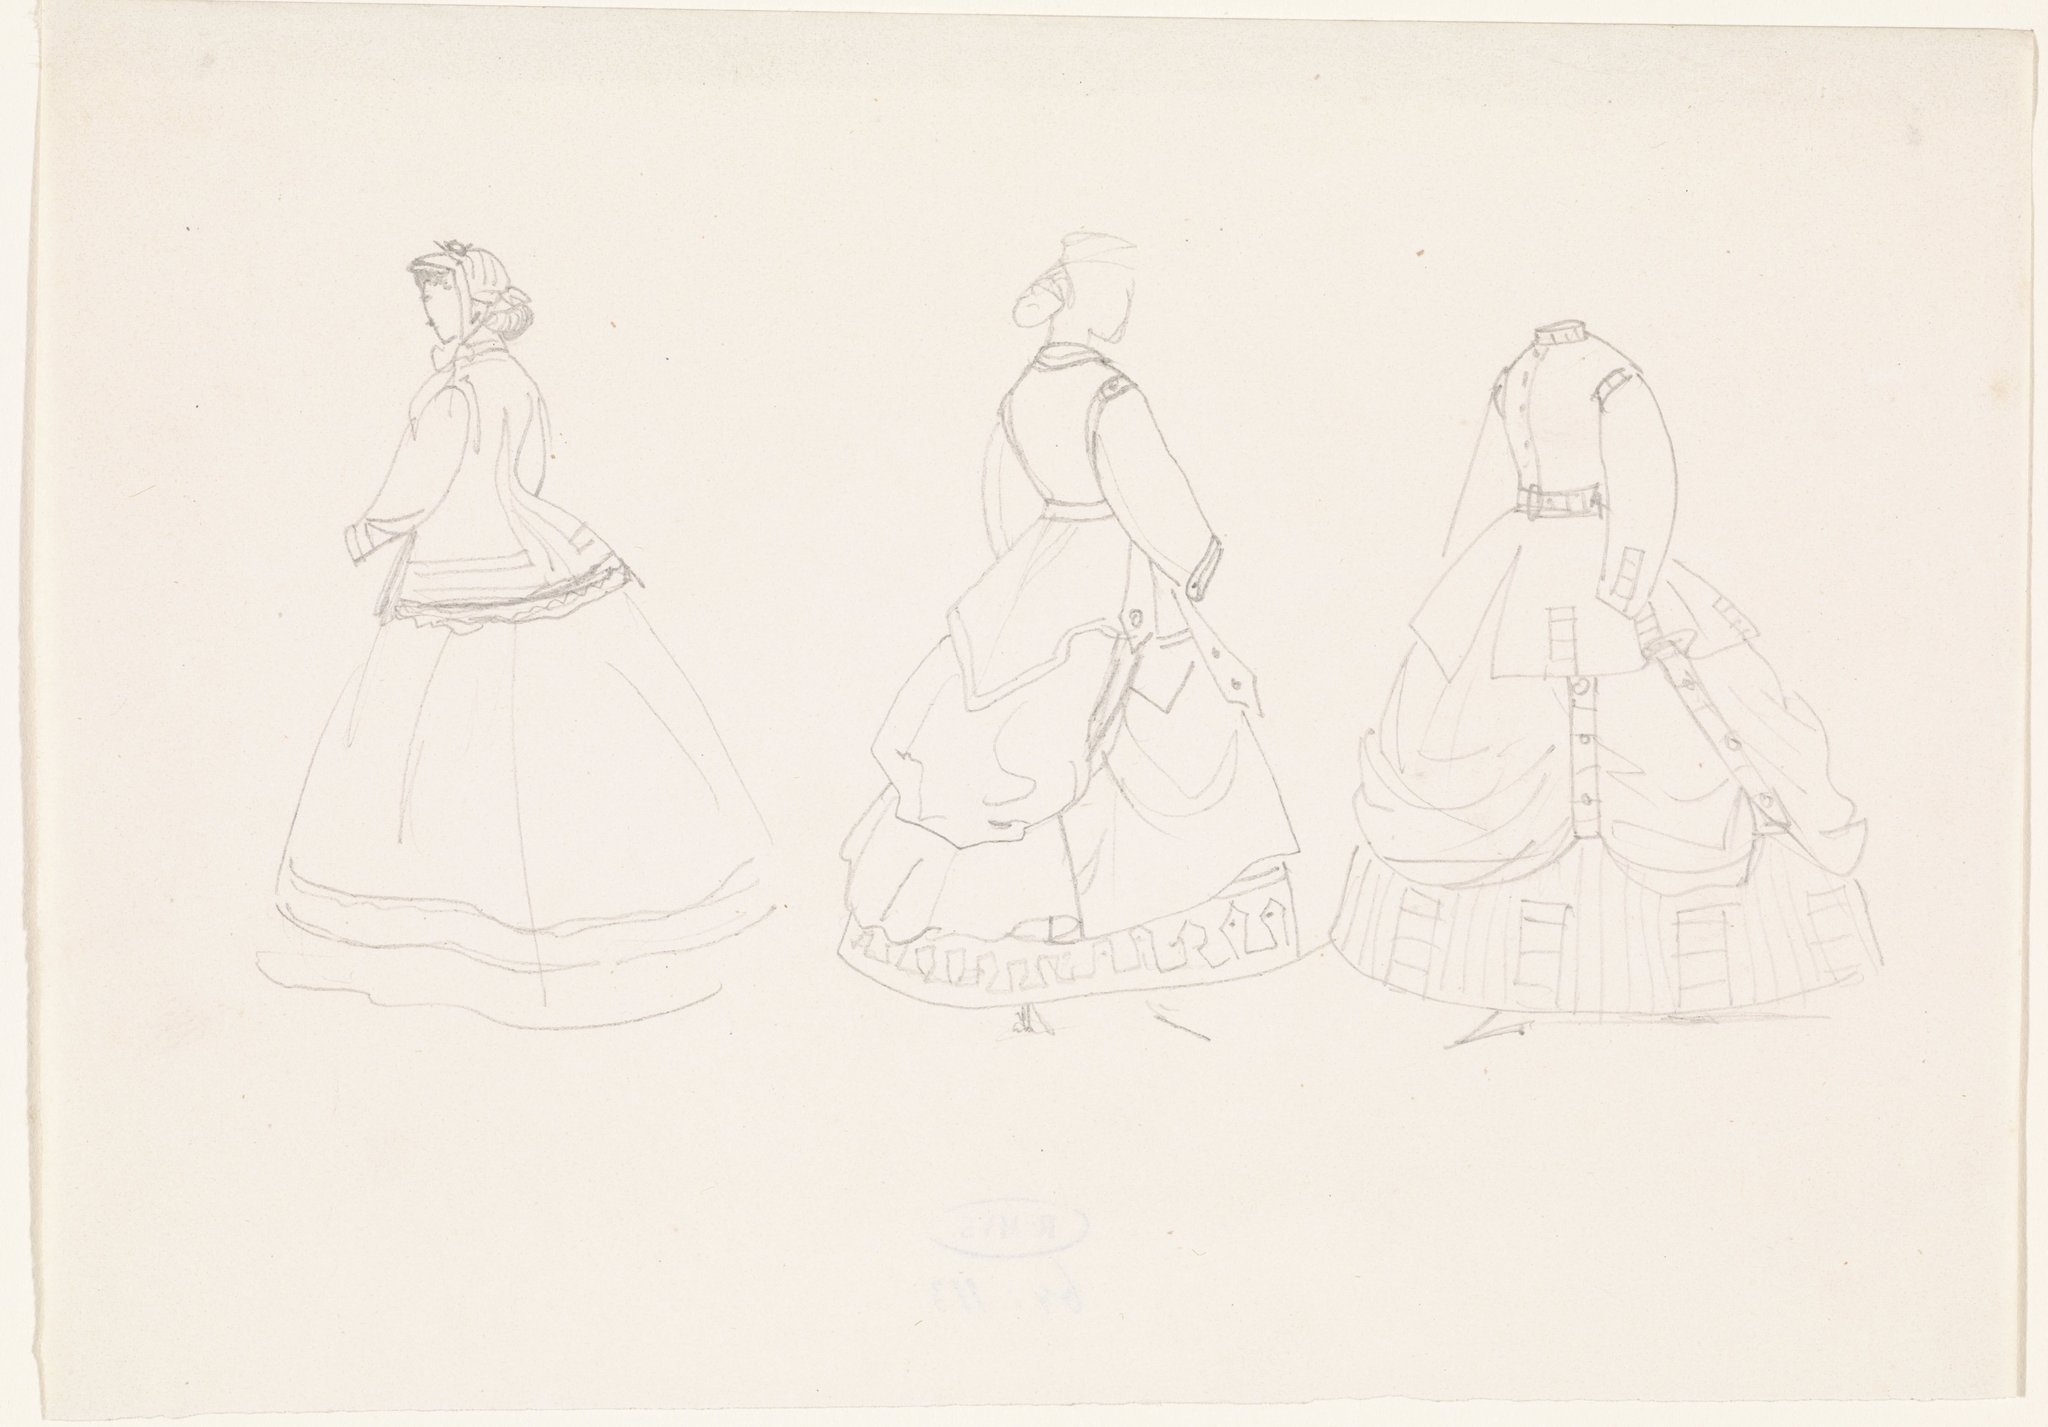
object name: drawing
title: Drie kostuumstudies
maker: willem de famars testas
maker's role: draughtsman, painter, print maker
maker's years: 1834-1896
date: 1844-1896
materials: paper, pencil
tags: clothes, costume (+ women's clothes), dress, gown (+ women's clothes)